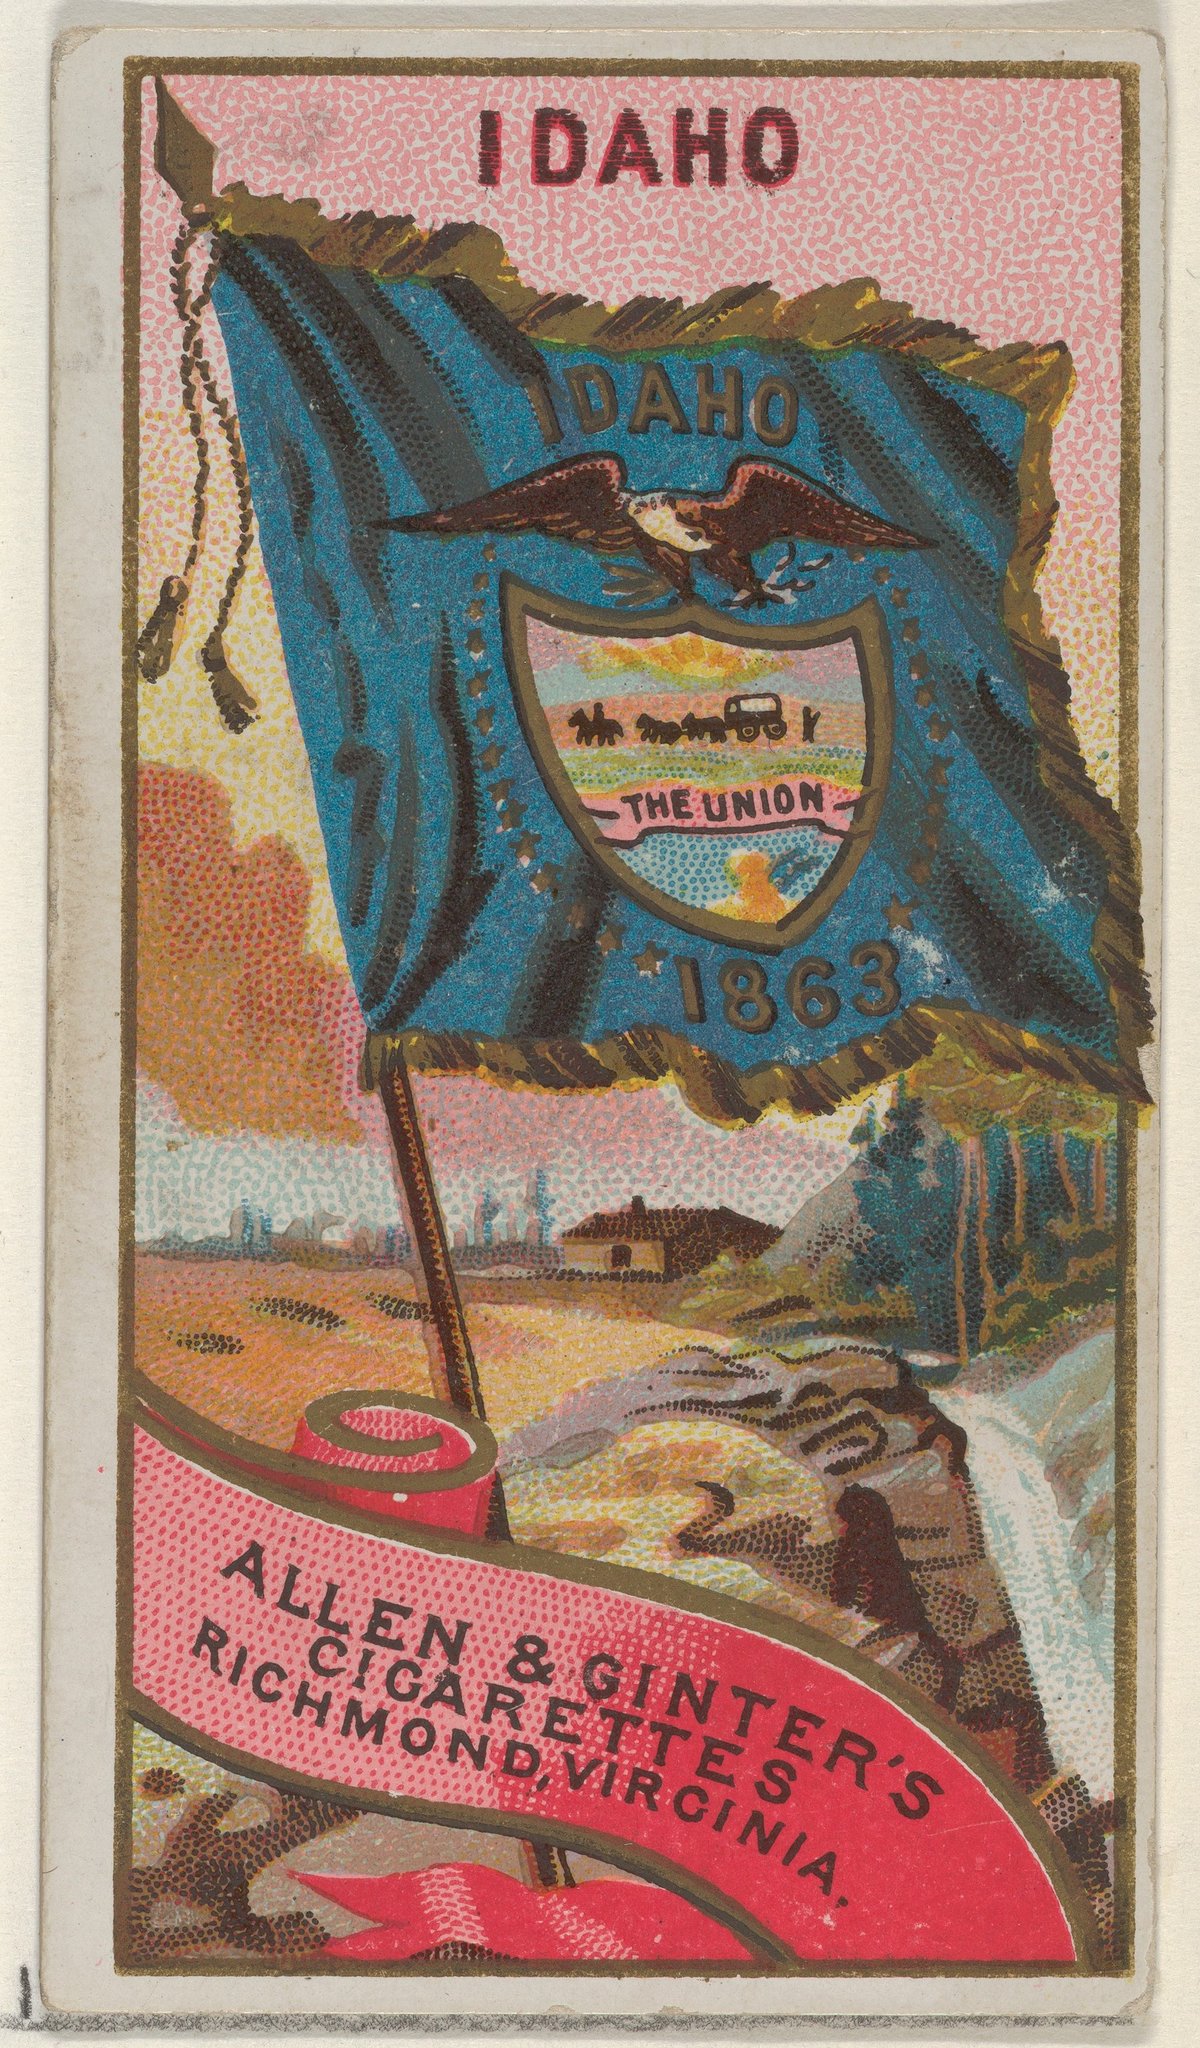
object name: print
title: Idaho, from Flags of the States and Territories (N11) for Allen & Ginter Cigarettes Brands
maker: allen & ginter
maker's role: publisher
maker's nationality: american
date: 1888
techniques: color lithograph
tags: flags